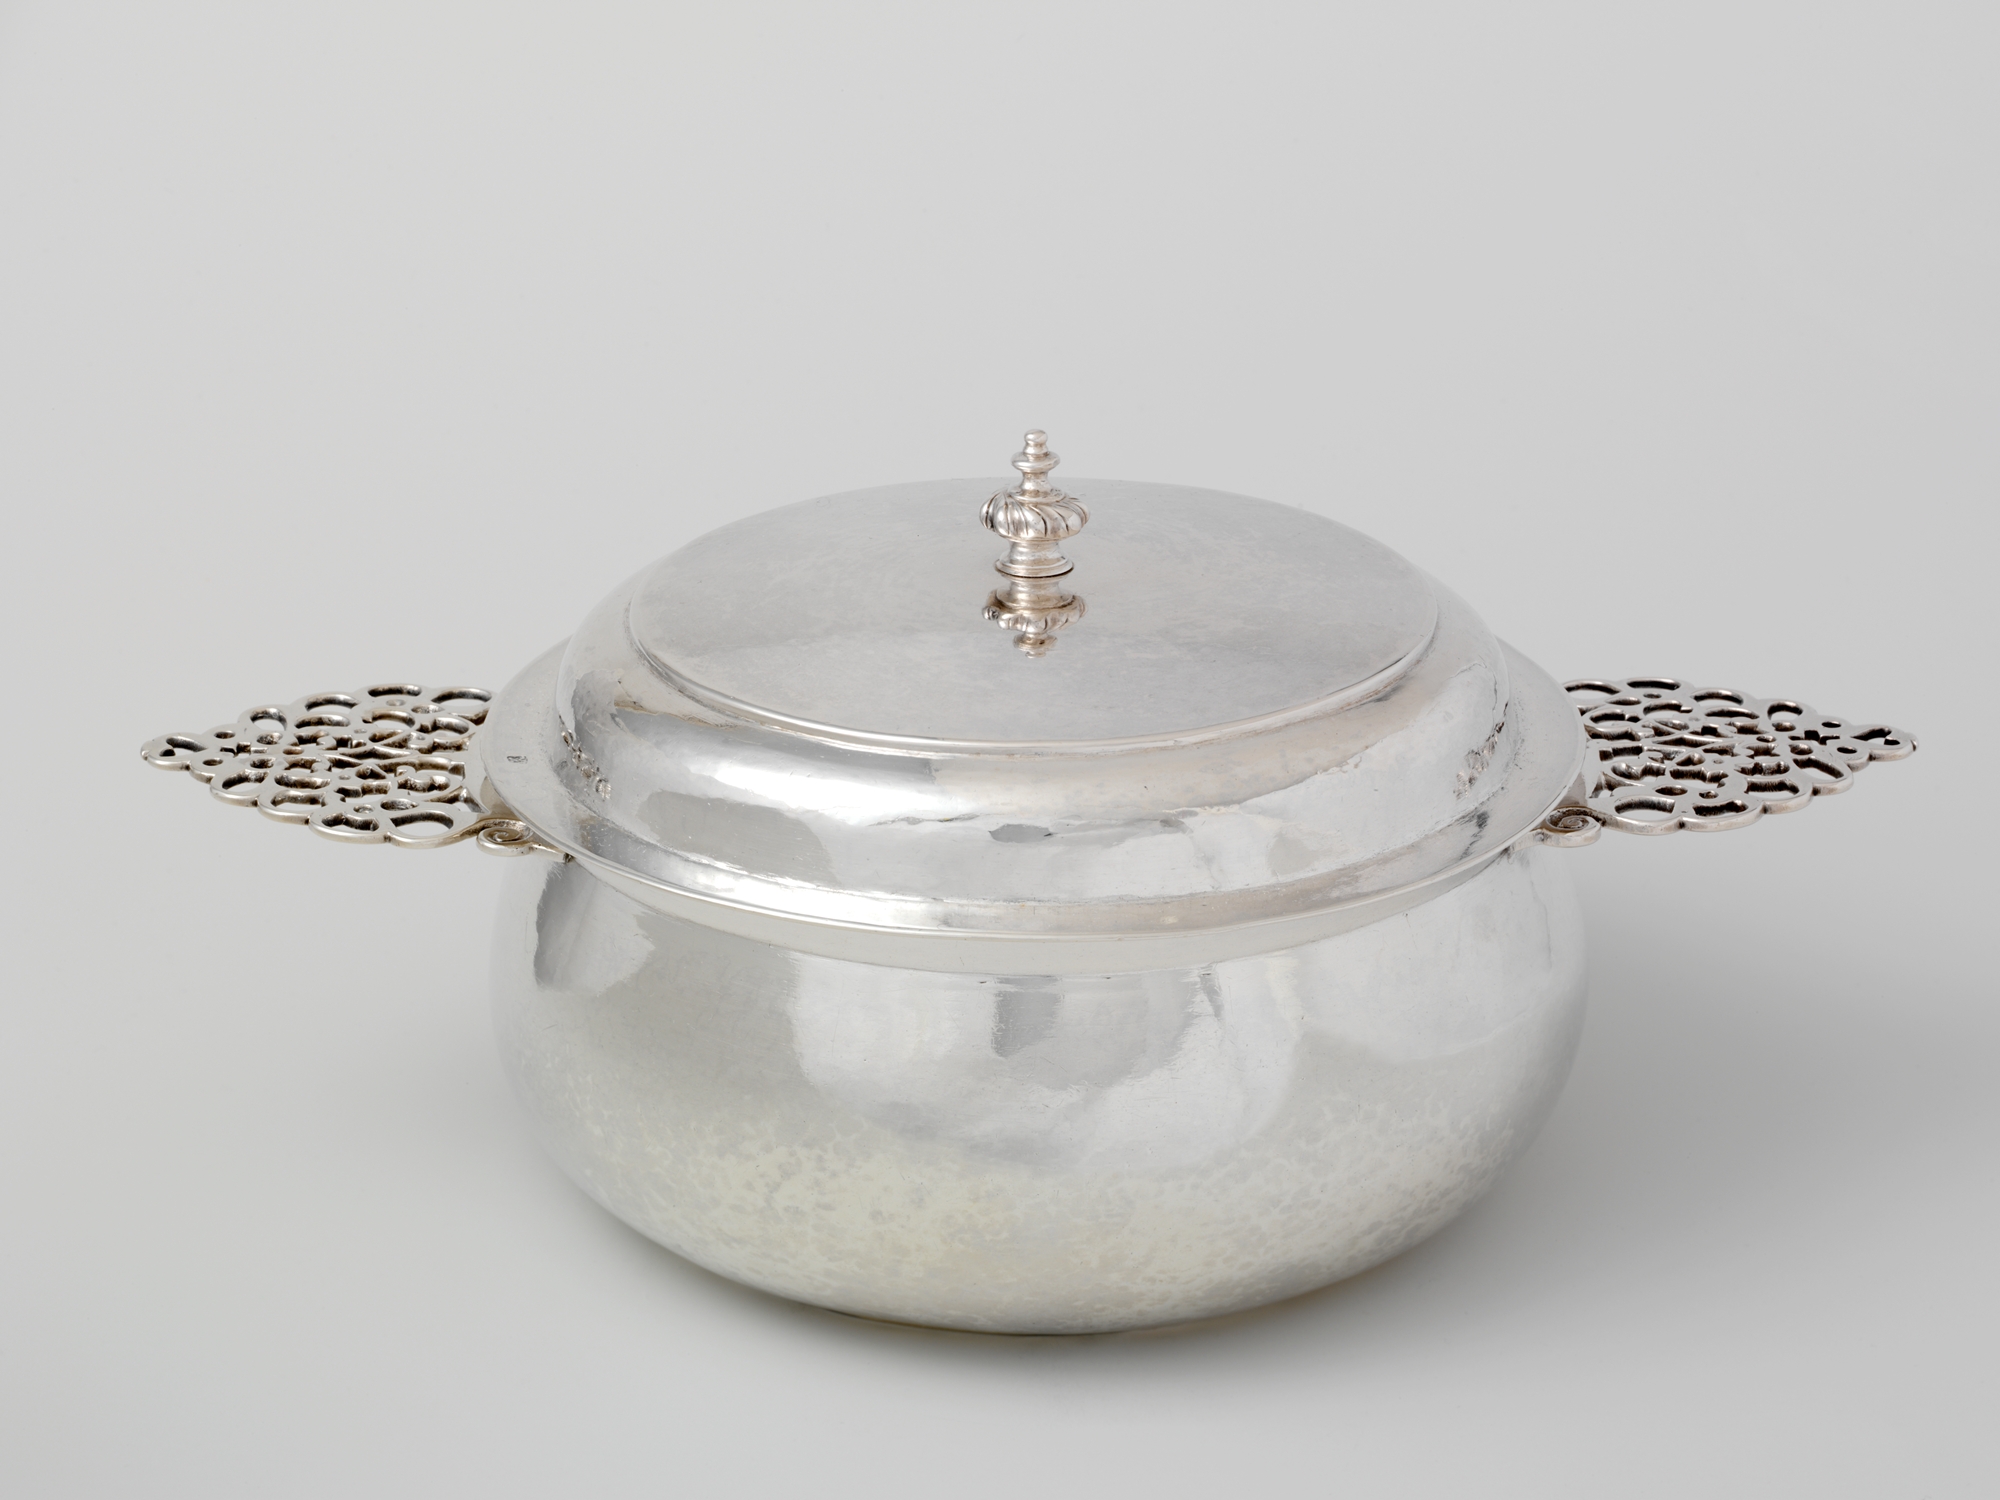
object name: porringer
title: Covered Porringer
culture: american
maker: ink or ivk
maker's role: maker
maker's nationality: american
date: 1700-1720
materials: silver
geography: united states